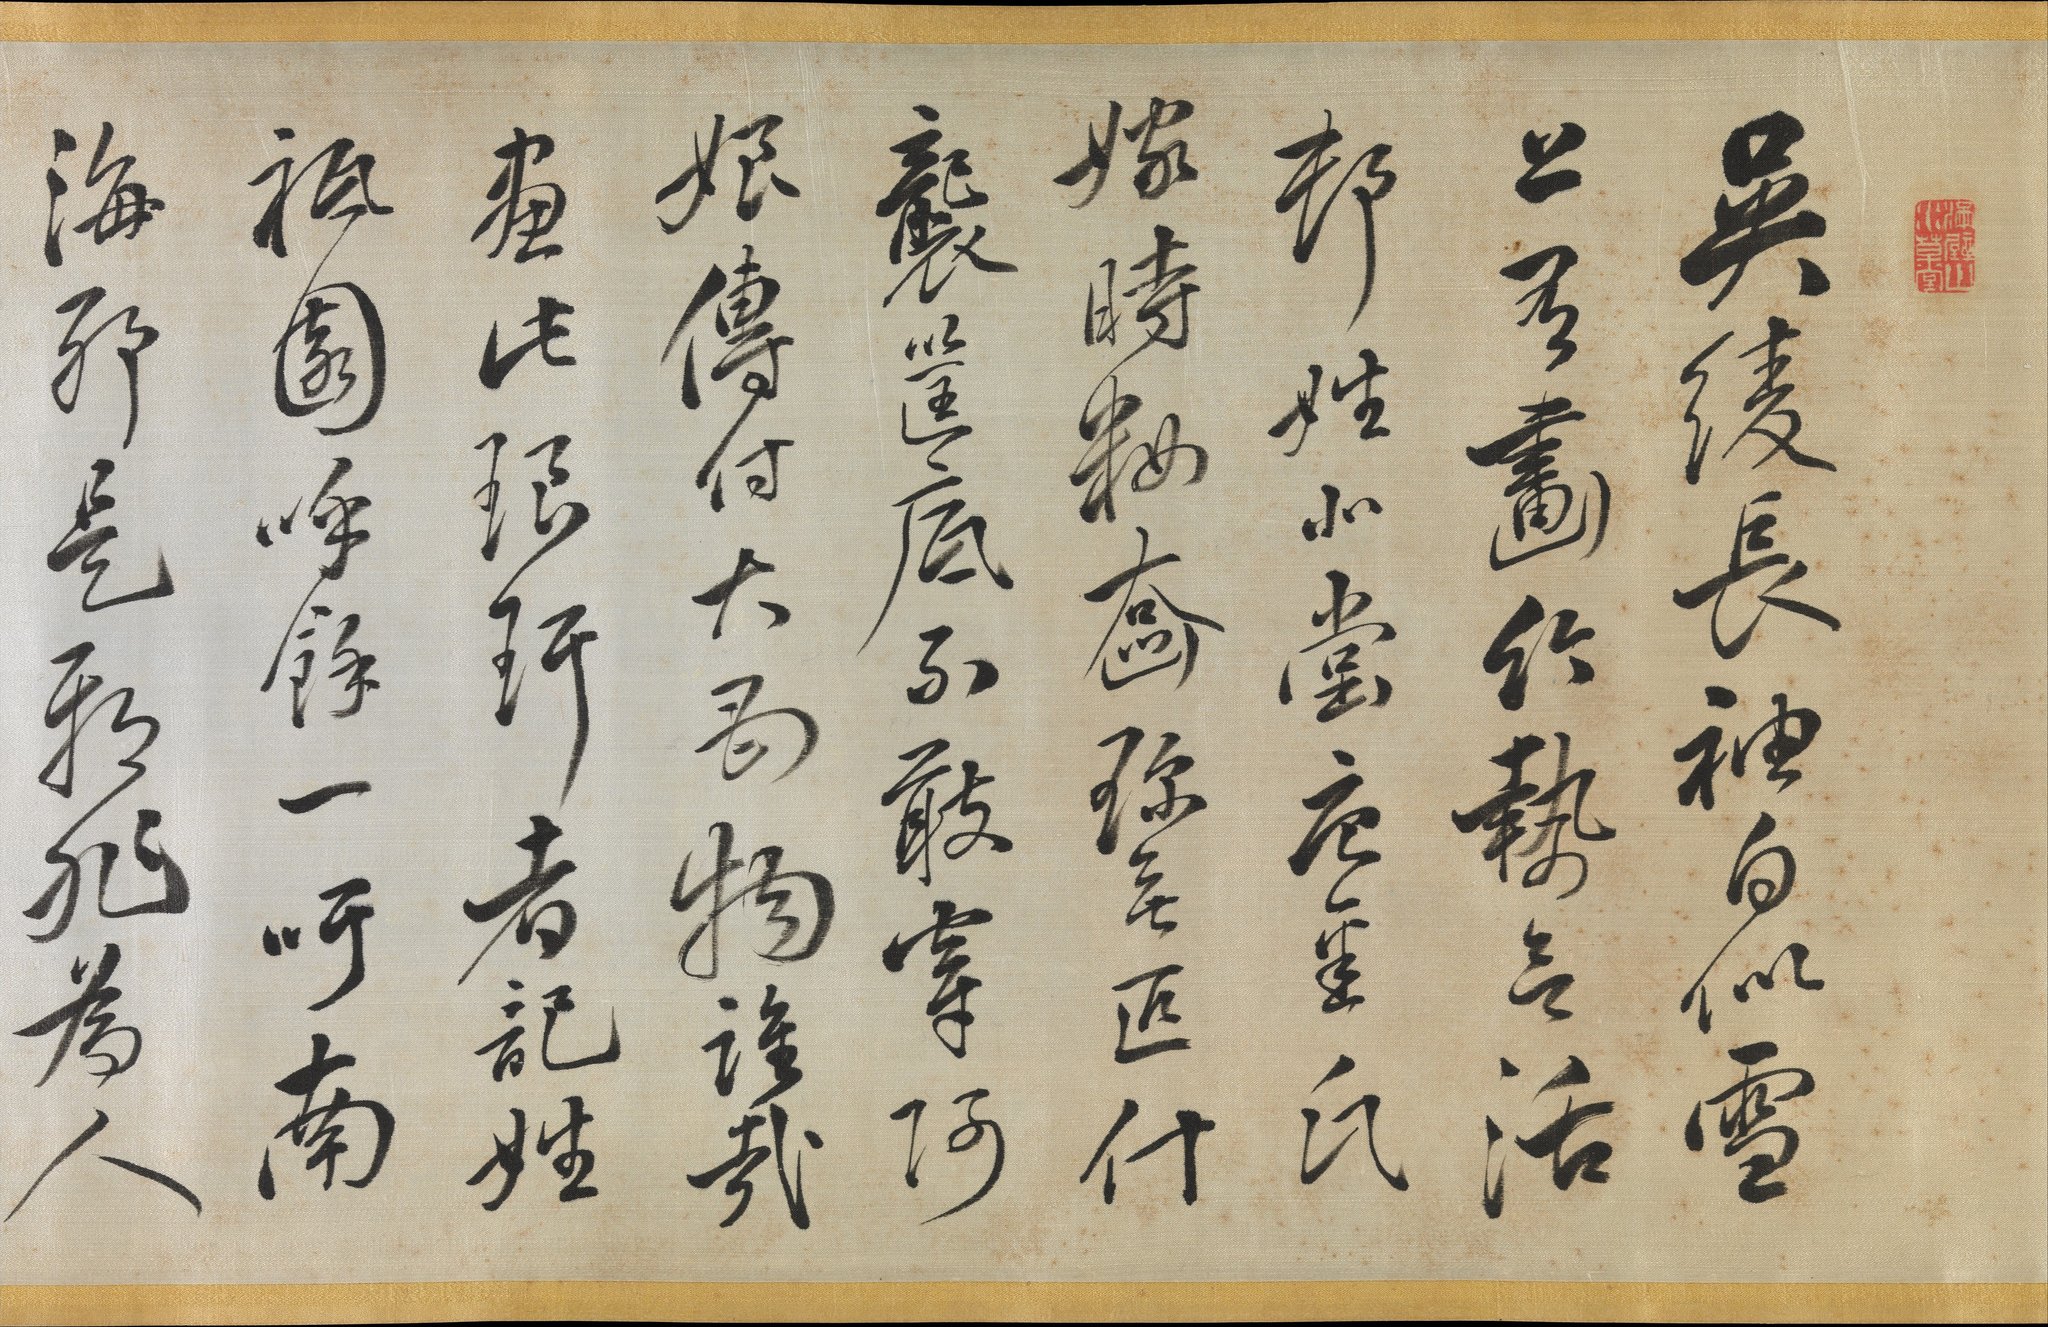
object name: handscroll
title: Poem Accompanying an Over Robe (Uchikake) with a Bamboo Painting by Gion Nankai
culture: japanese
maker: rai san’yō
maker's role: artist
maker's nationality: japanese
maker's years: 1780-1832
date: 1824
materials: ink, silk